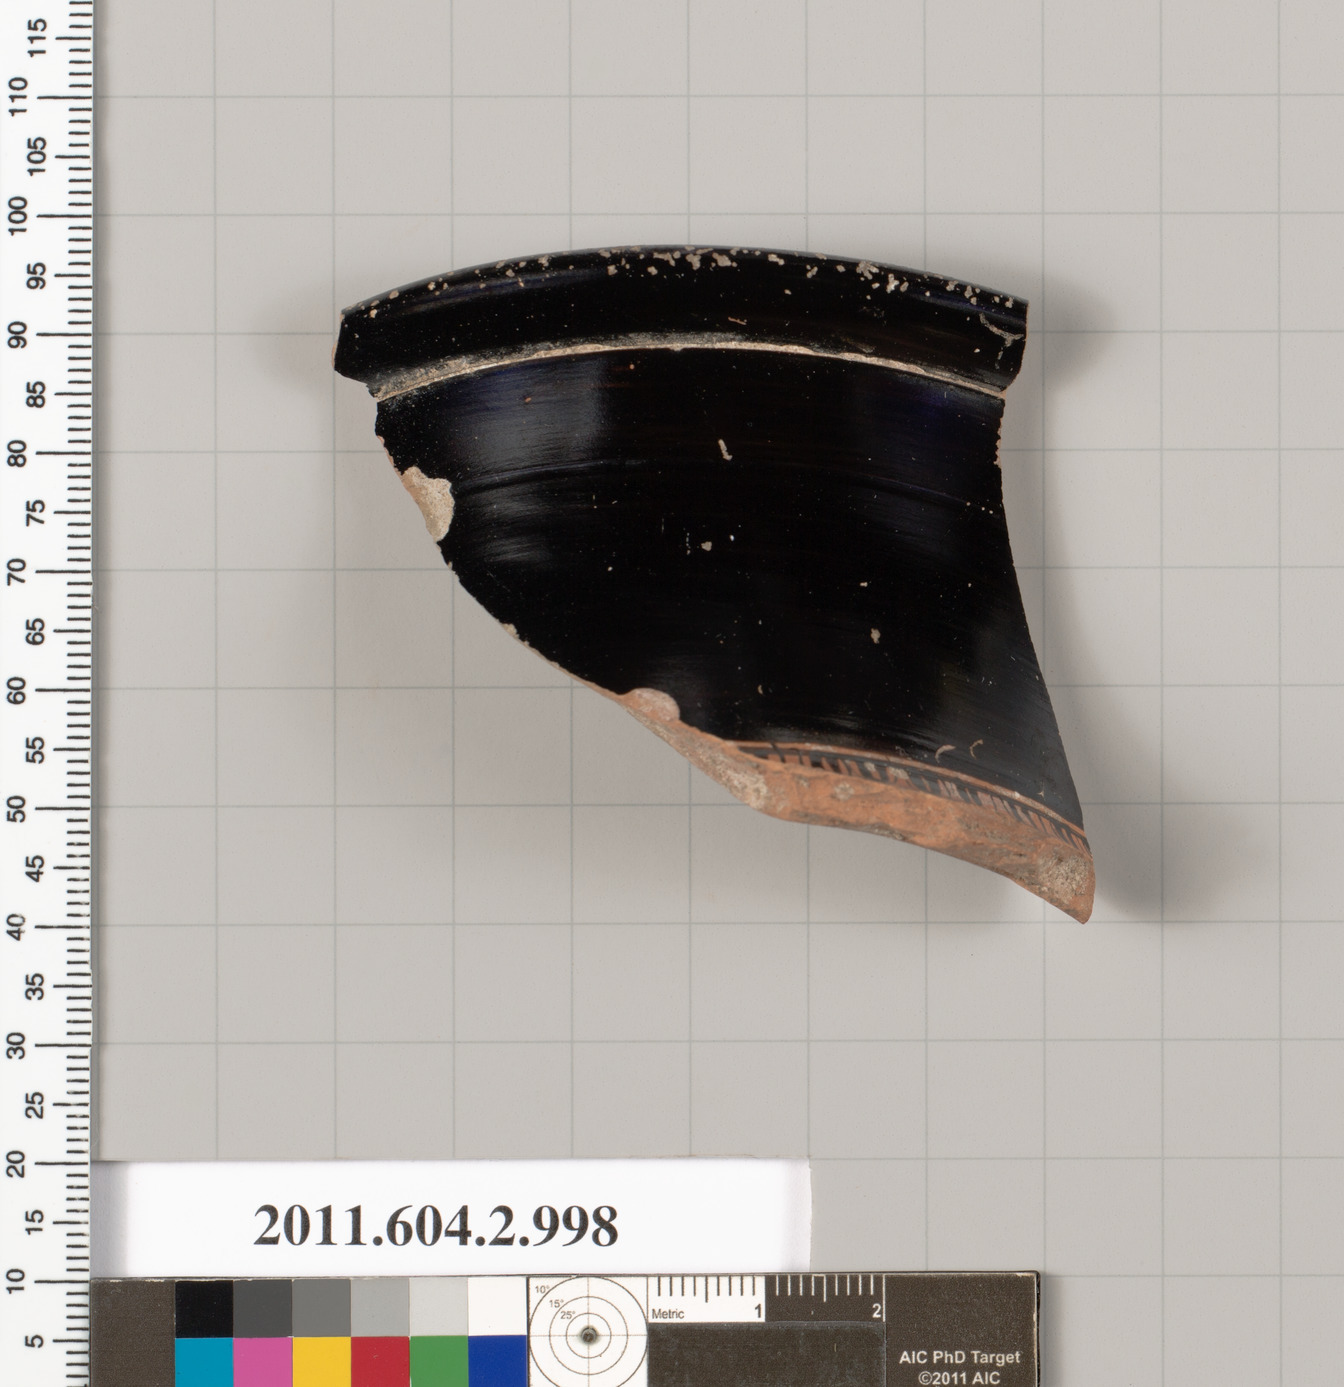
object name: olpe fragment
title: Terracotta fragment of an oinochoe: olpe (jug)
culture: greek, attic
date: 460-440 BCE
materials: terracotta